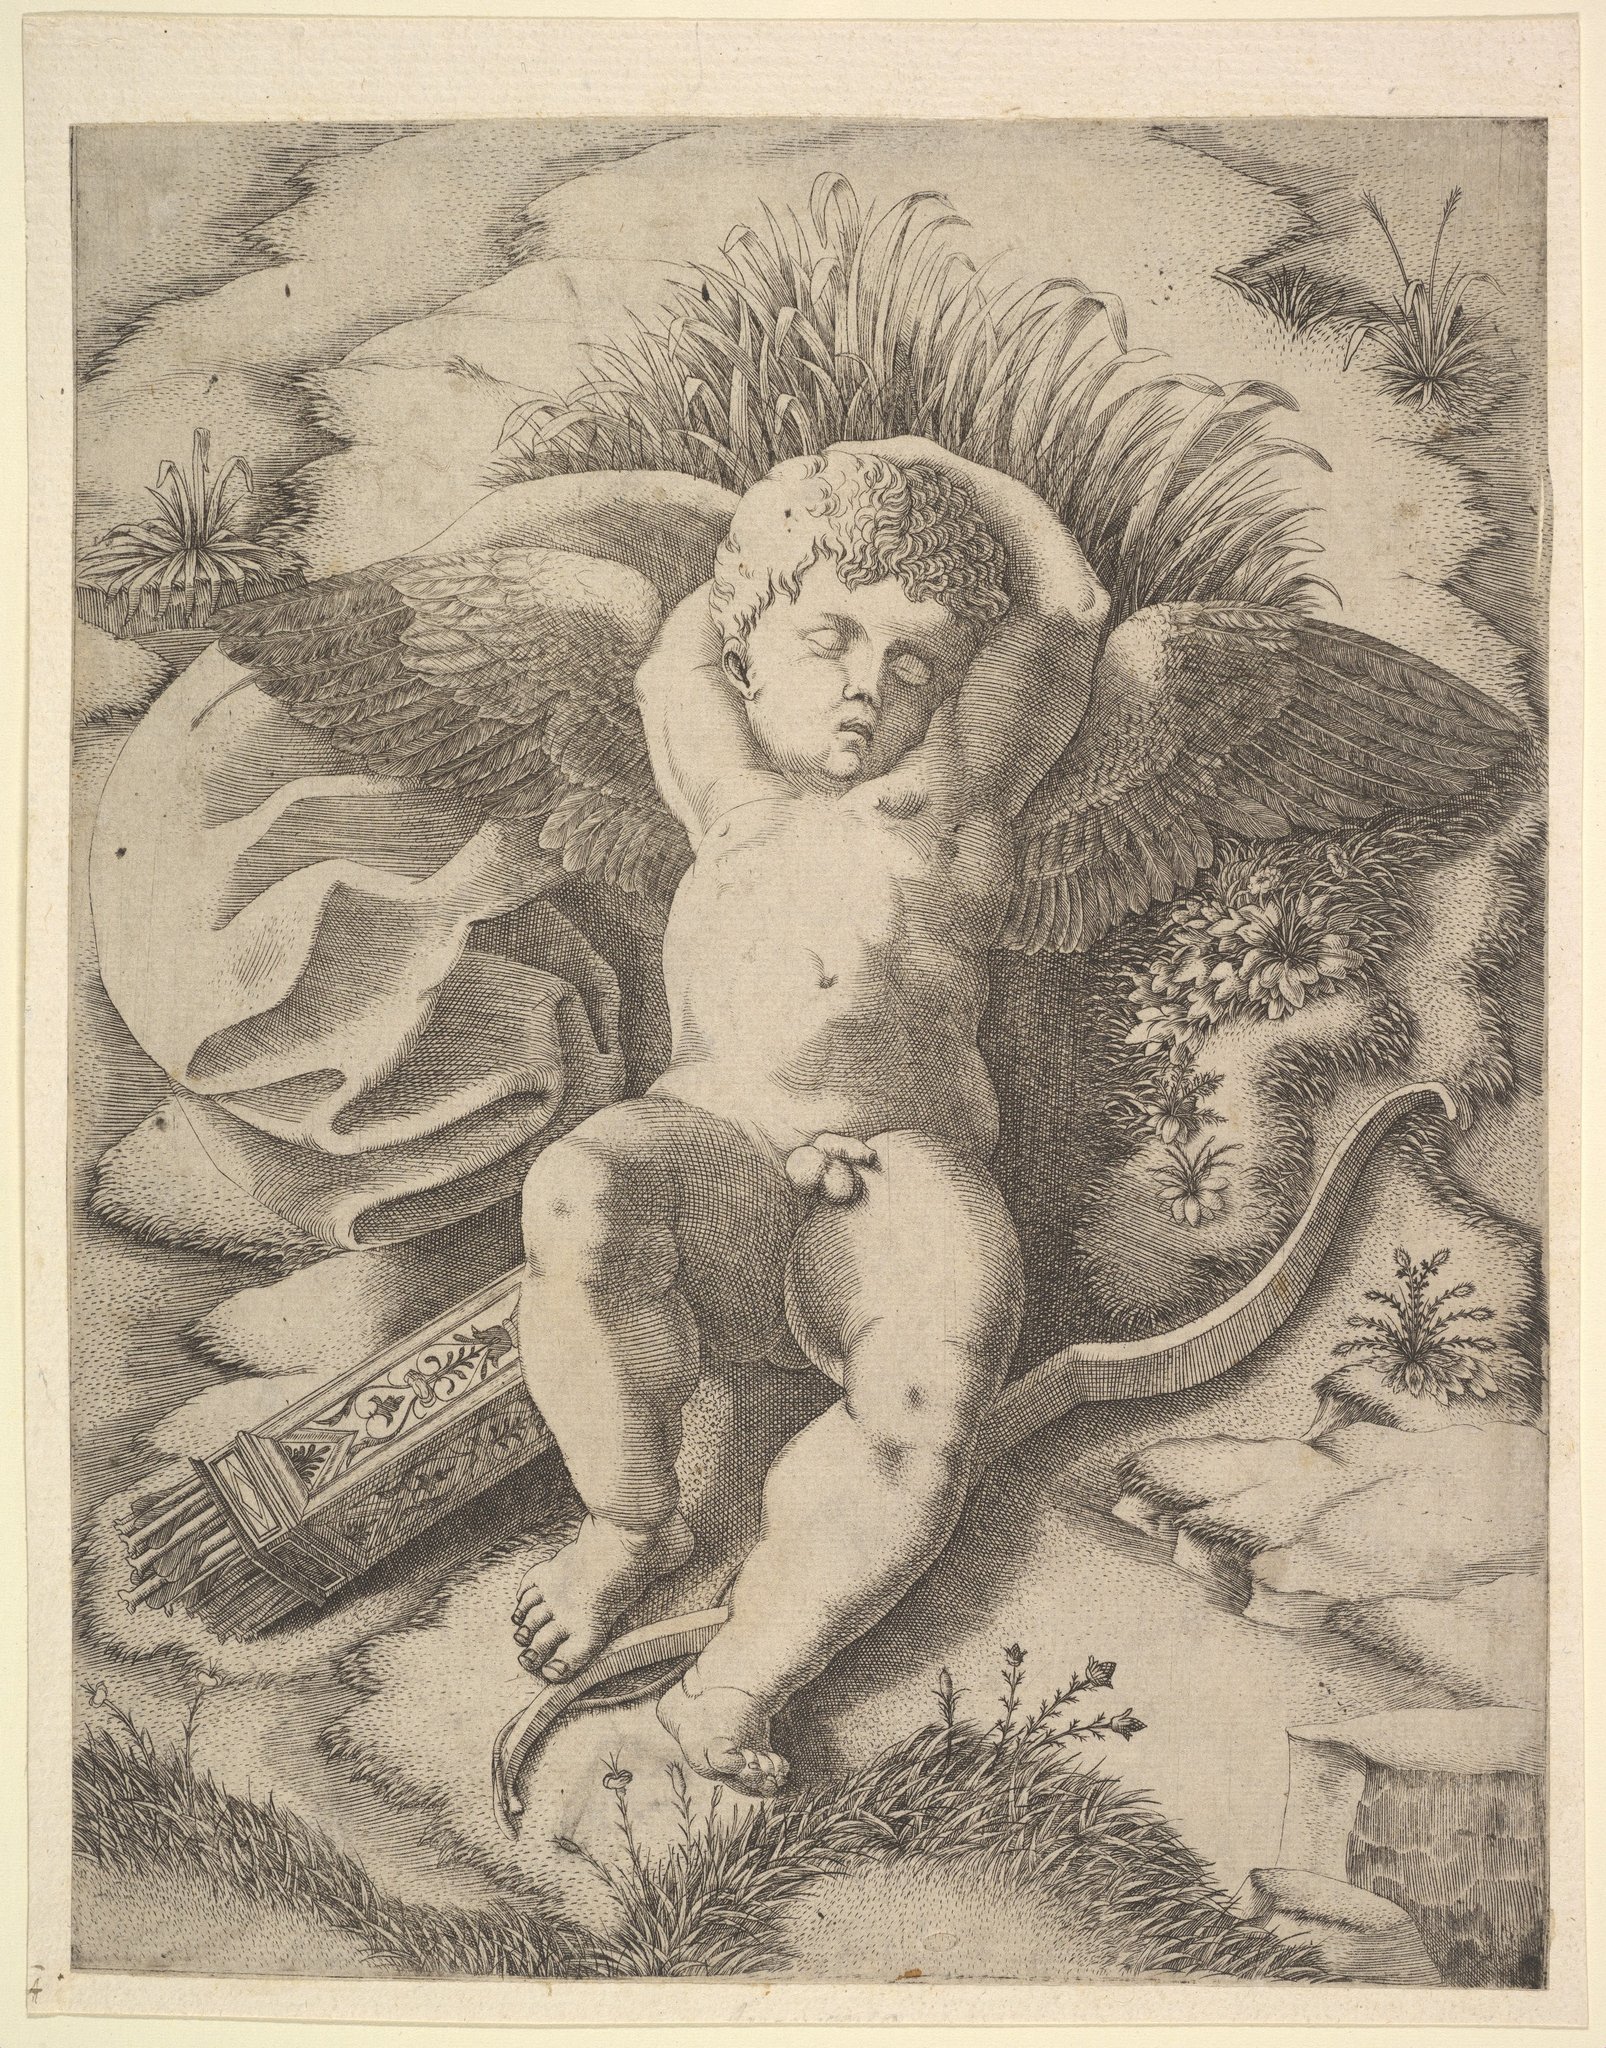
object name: print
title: Cupid Sleeping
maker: anonymous, italian, 16th century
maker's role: artist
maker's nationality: italian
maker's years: 1500-1600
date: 1501-1600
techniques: engraving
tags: sleeping,cupid